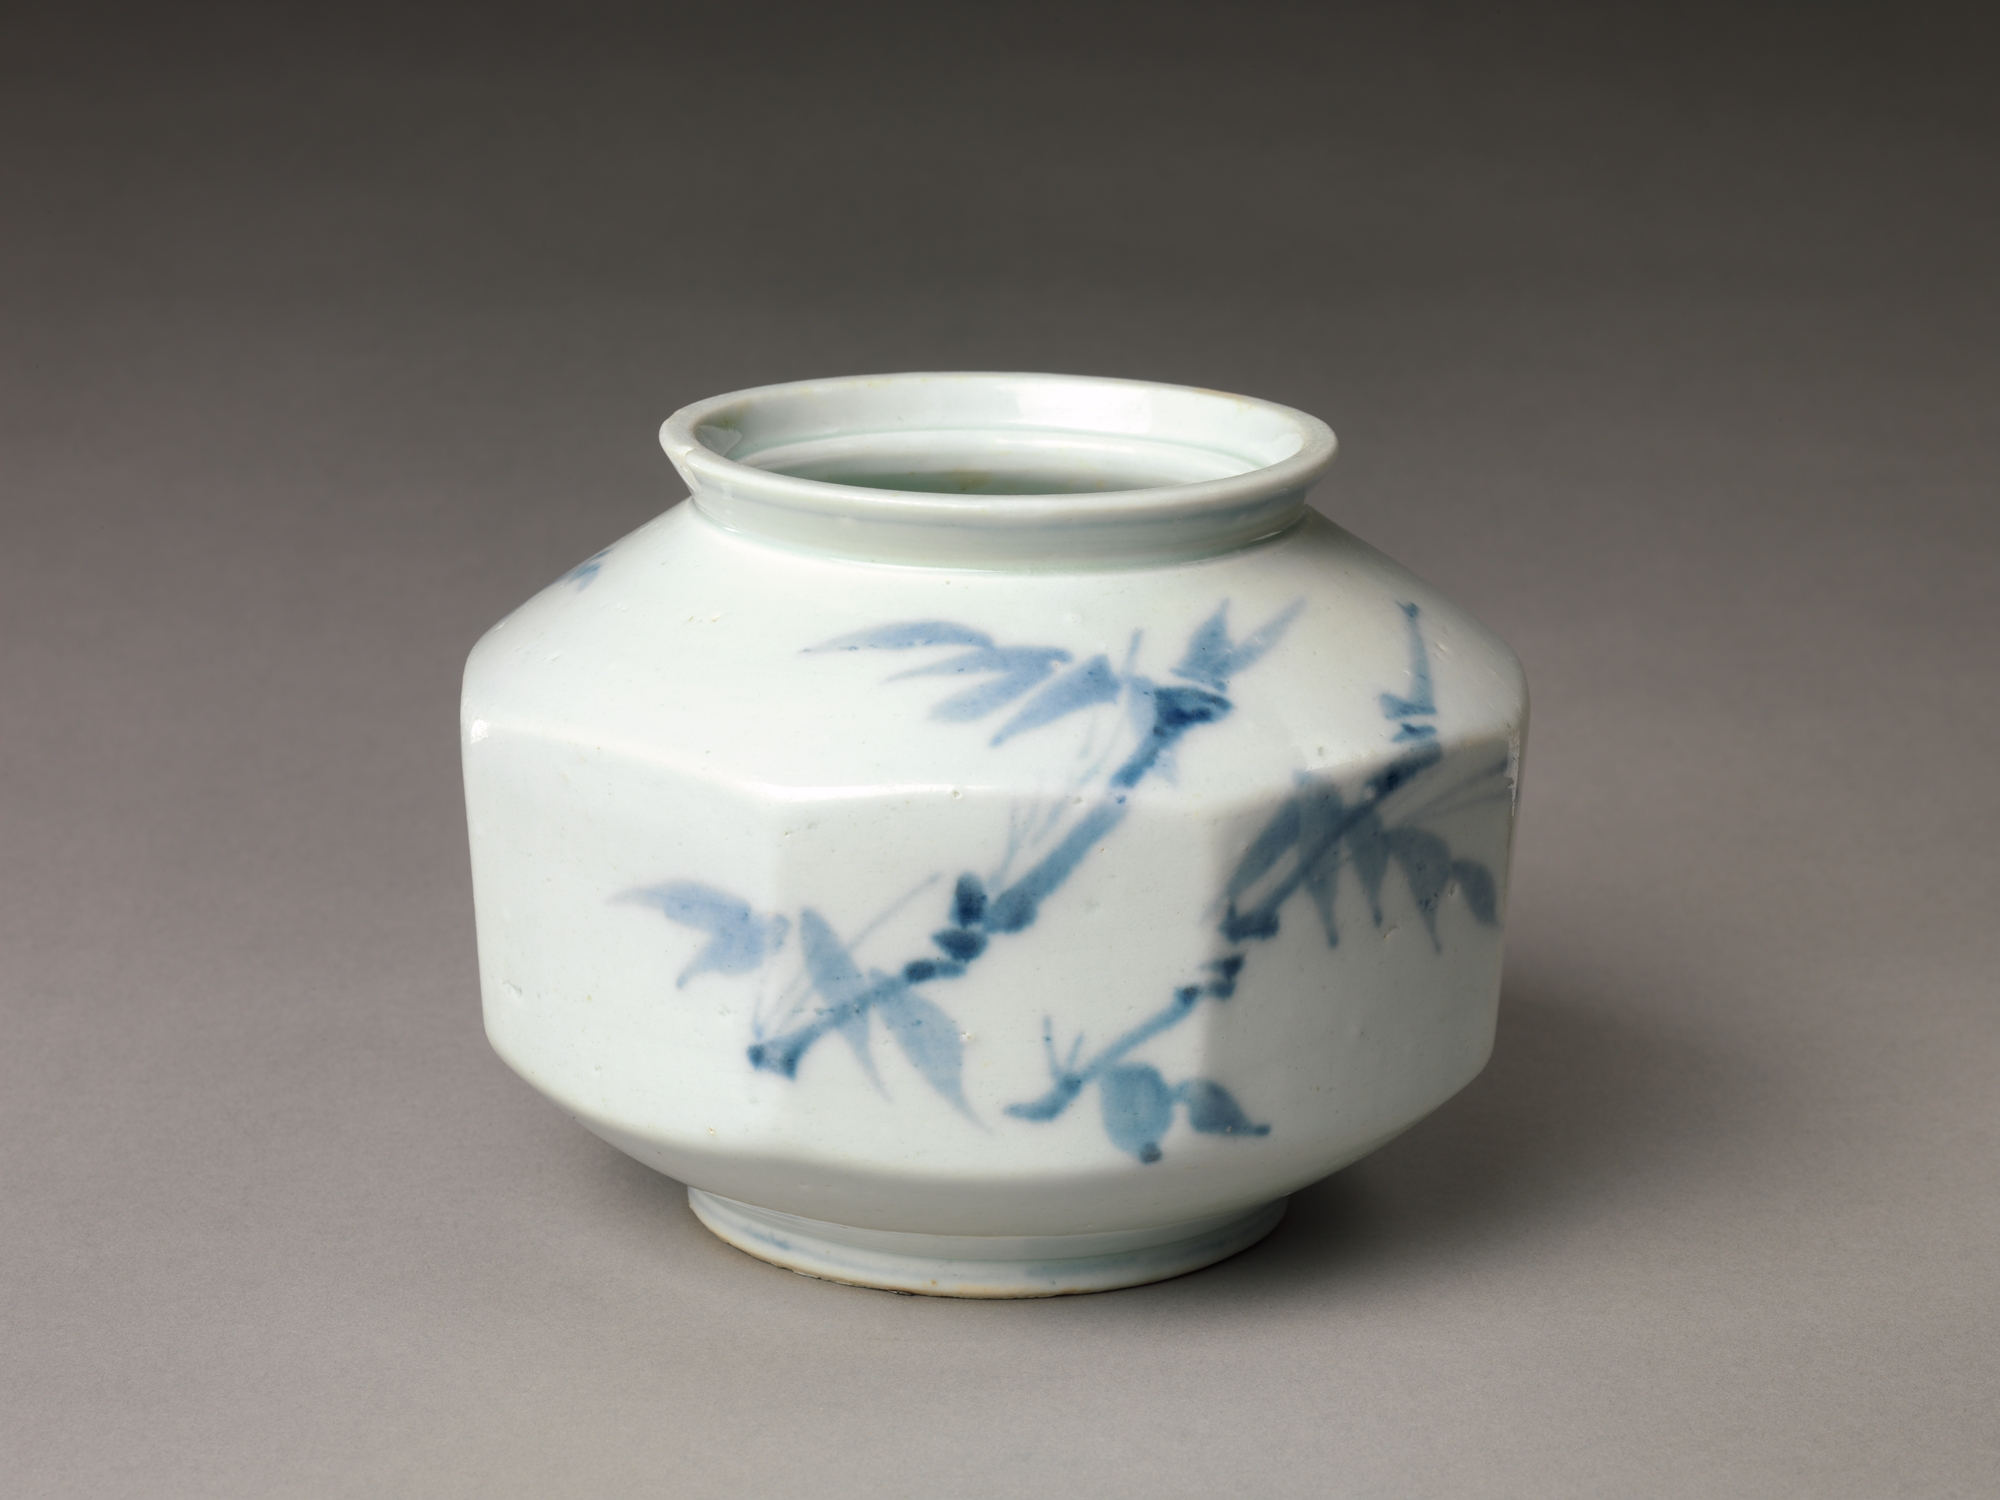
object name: jar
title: Faceted jar decorated with plum blossoms and bamboo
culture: korean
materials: cobalt, porcelain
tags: bamboo